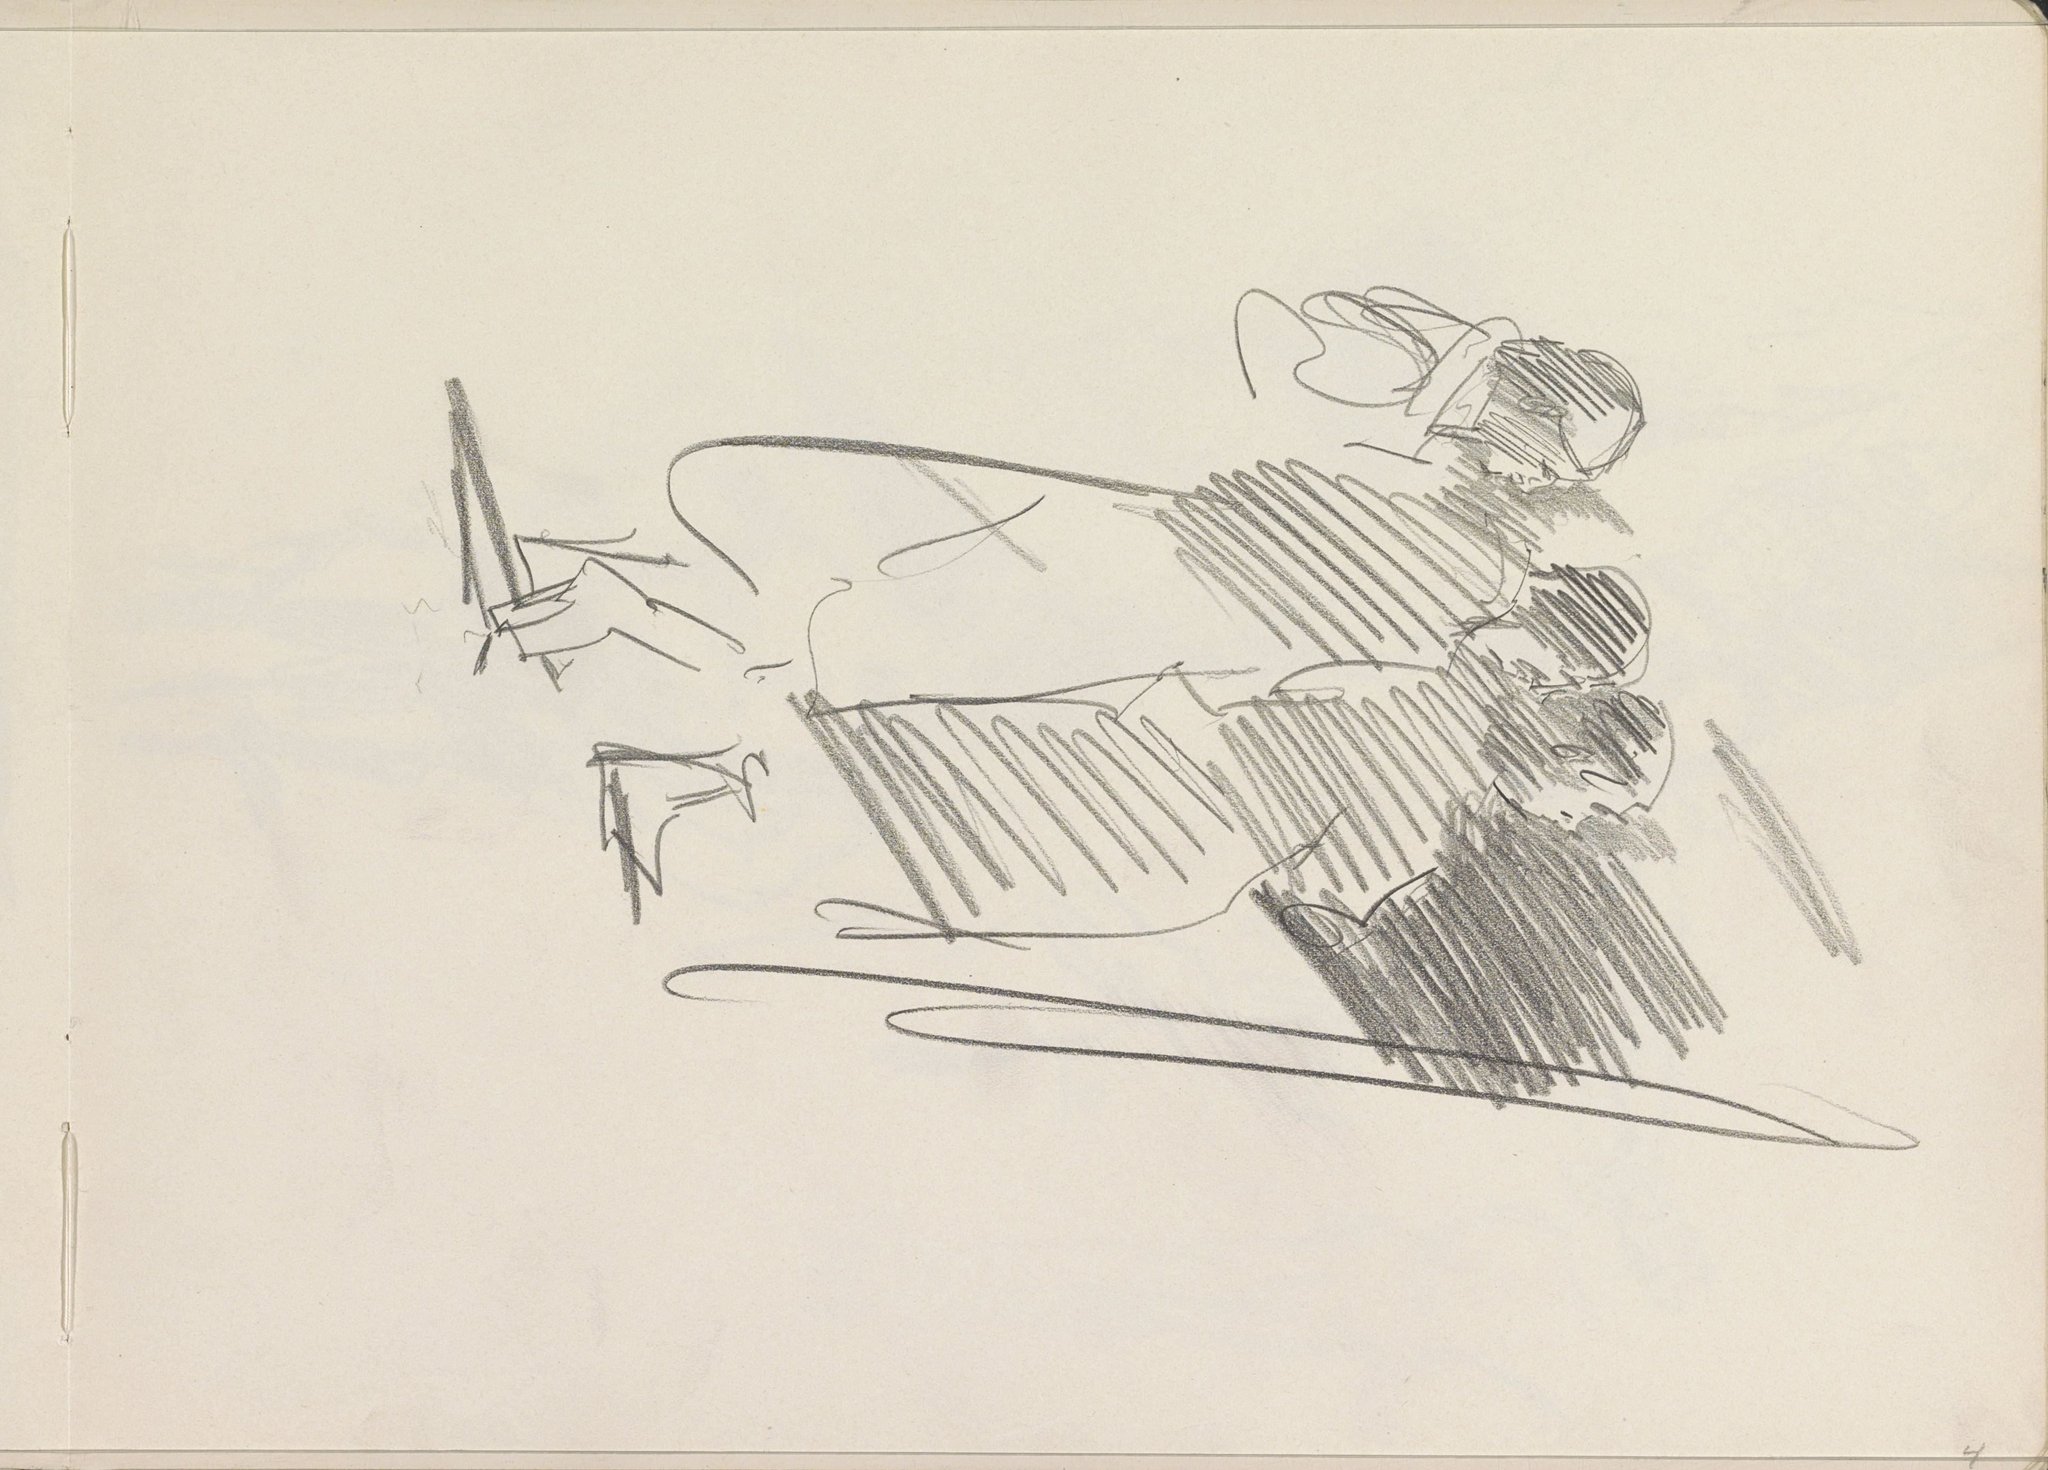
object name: sketchbook leaf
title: Drie staande figuren op een rij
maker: isaac israels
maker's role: draughtsman, painter, print maker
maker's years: 1865-1934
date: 1875-1934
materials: paper, pencil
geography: the hague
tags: standing figure (+ three persons)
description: Blad 4 recto uit schetsboek V met 33 bladen.